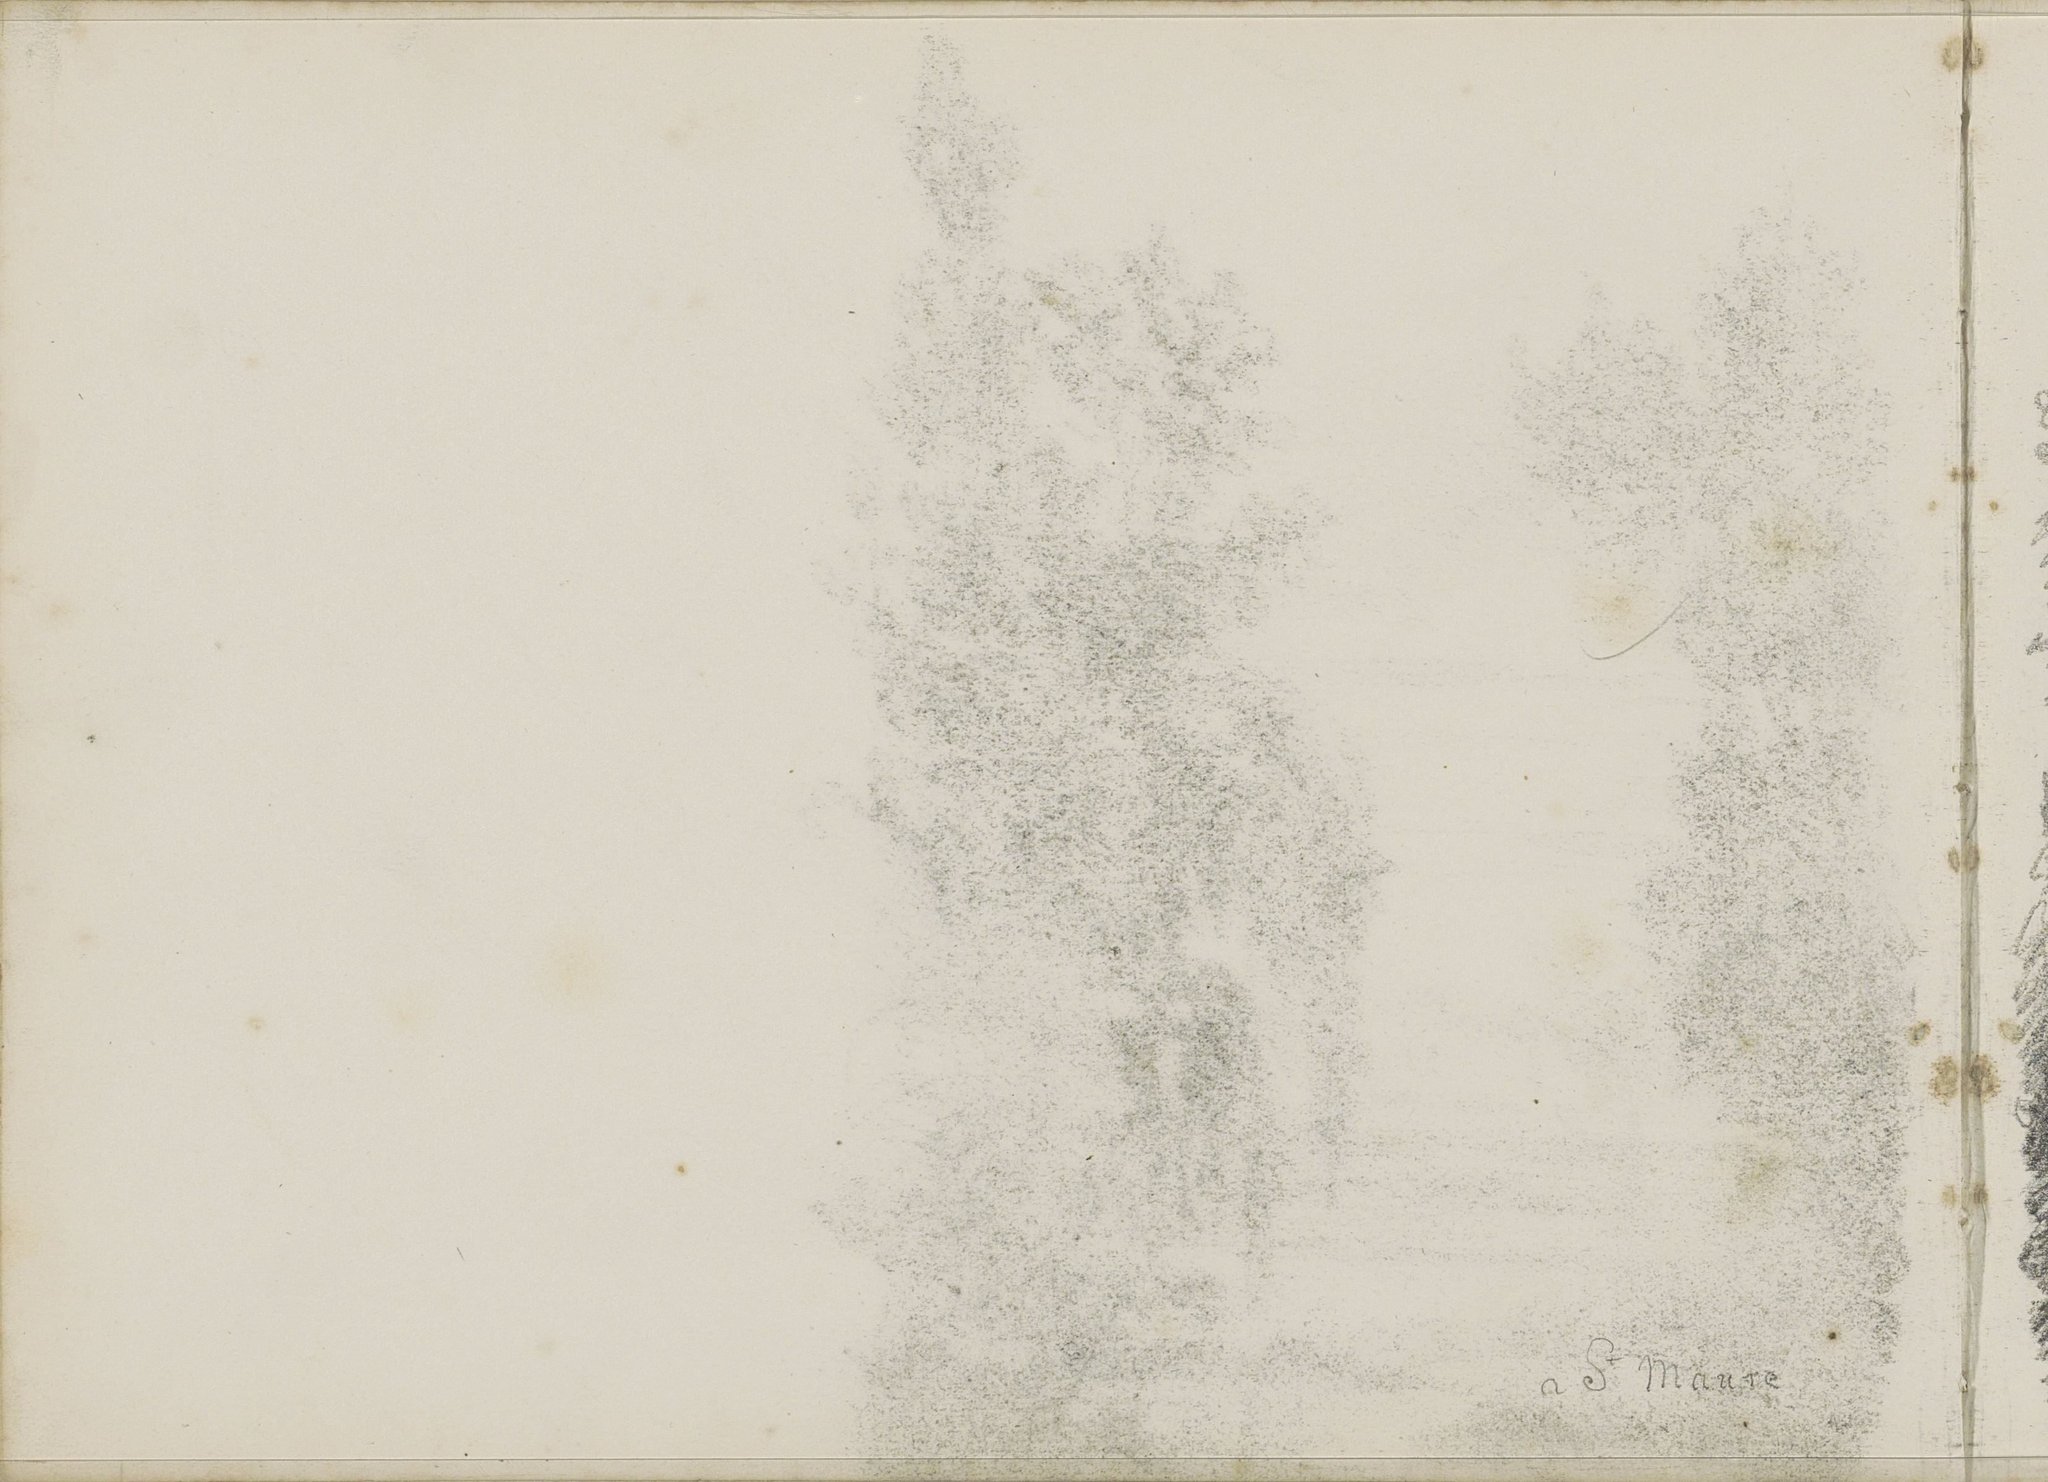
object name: sketchbook leaf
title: Notitie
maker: gerrit postma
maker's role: draughtsman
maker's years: 1819-1894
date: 1858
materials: paper, pencil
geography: sainte-maure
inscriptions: annotation: ‘a St Maure’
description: Blad 14 verso uit een schetsboek met 52 bladen.